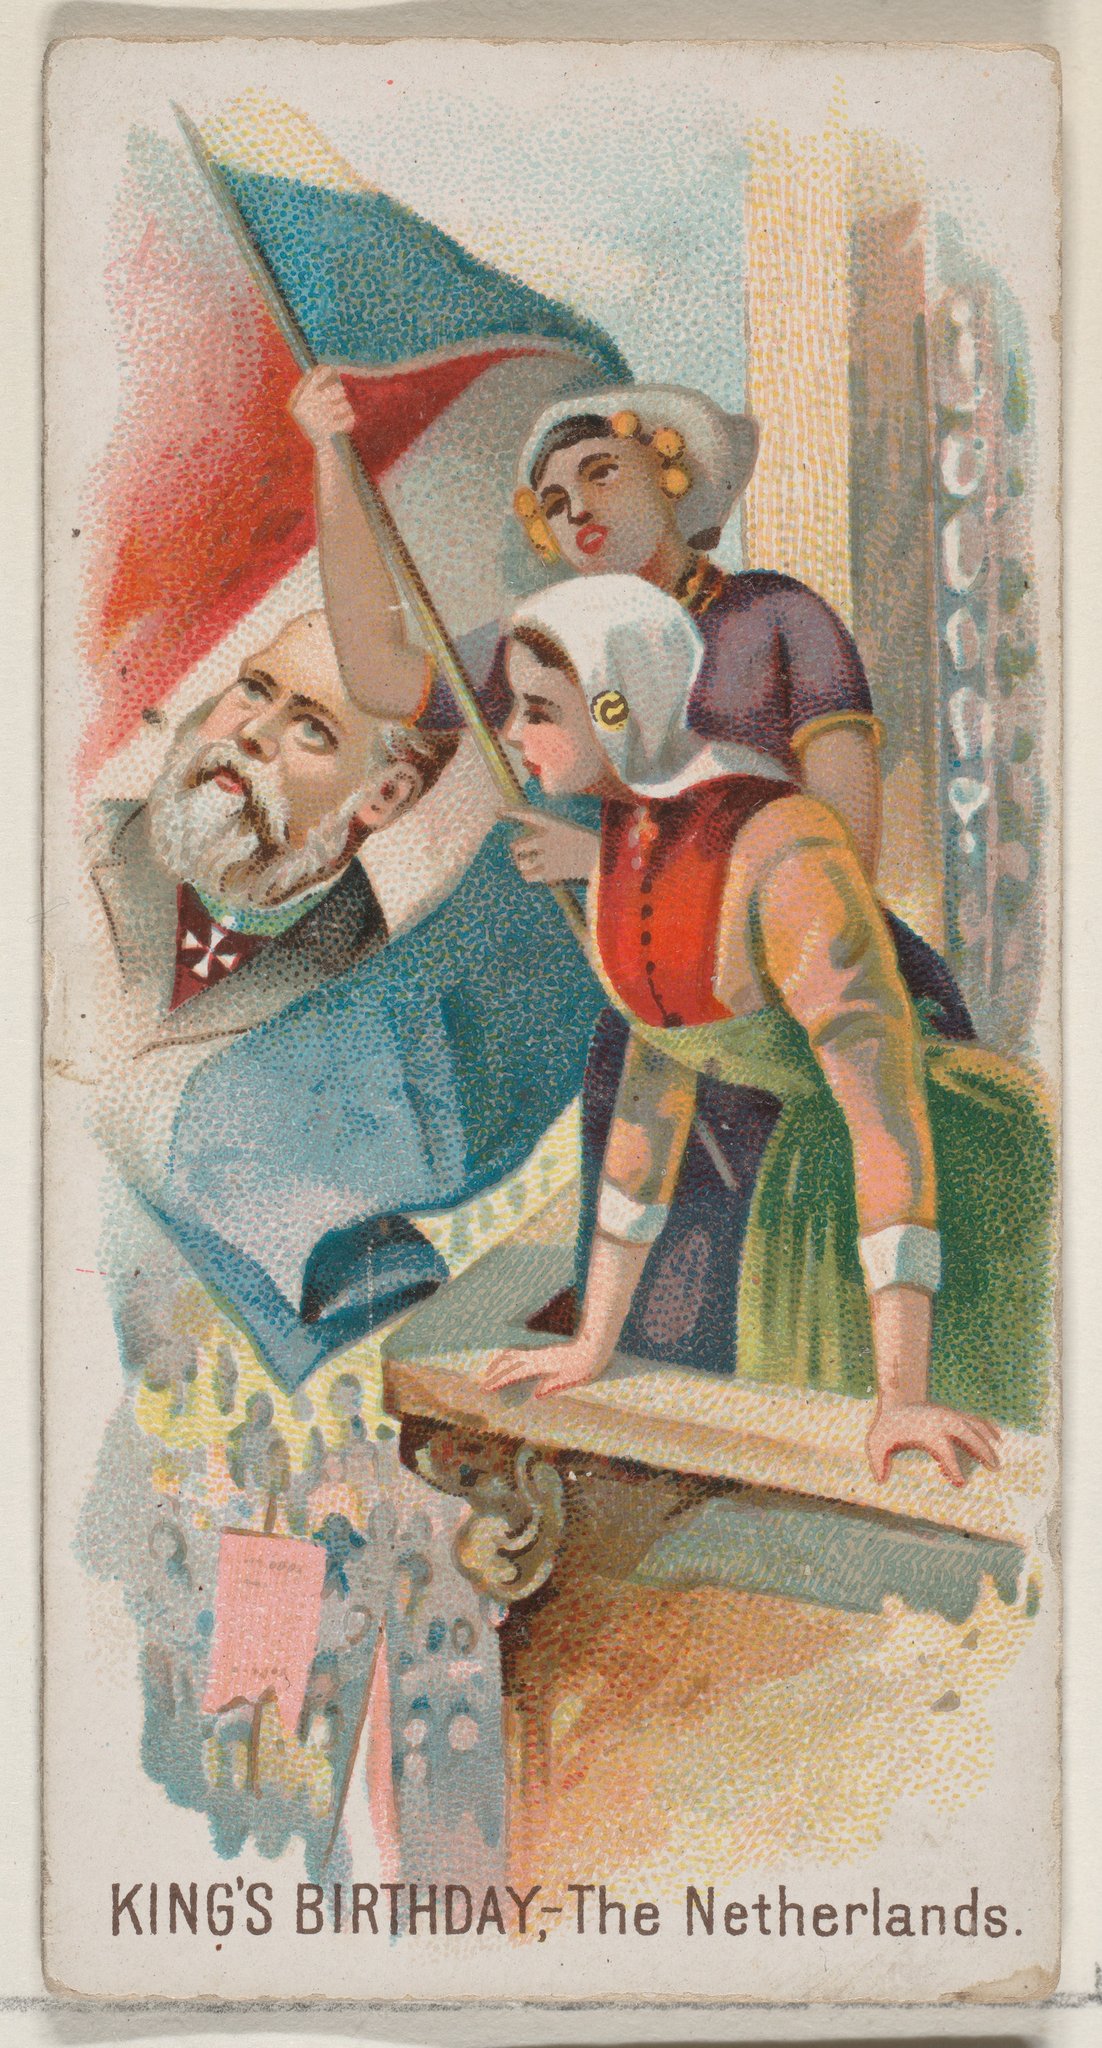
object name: print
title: King's Birthday, The Netherlands, from the Holidays series (N80) for Duke brand cigarettes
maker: w. duke, sons & co.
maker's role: publisher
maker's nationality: american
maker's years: 1870-1920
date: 1890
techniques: color lithograph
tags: women